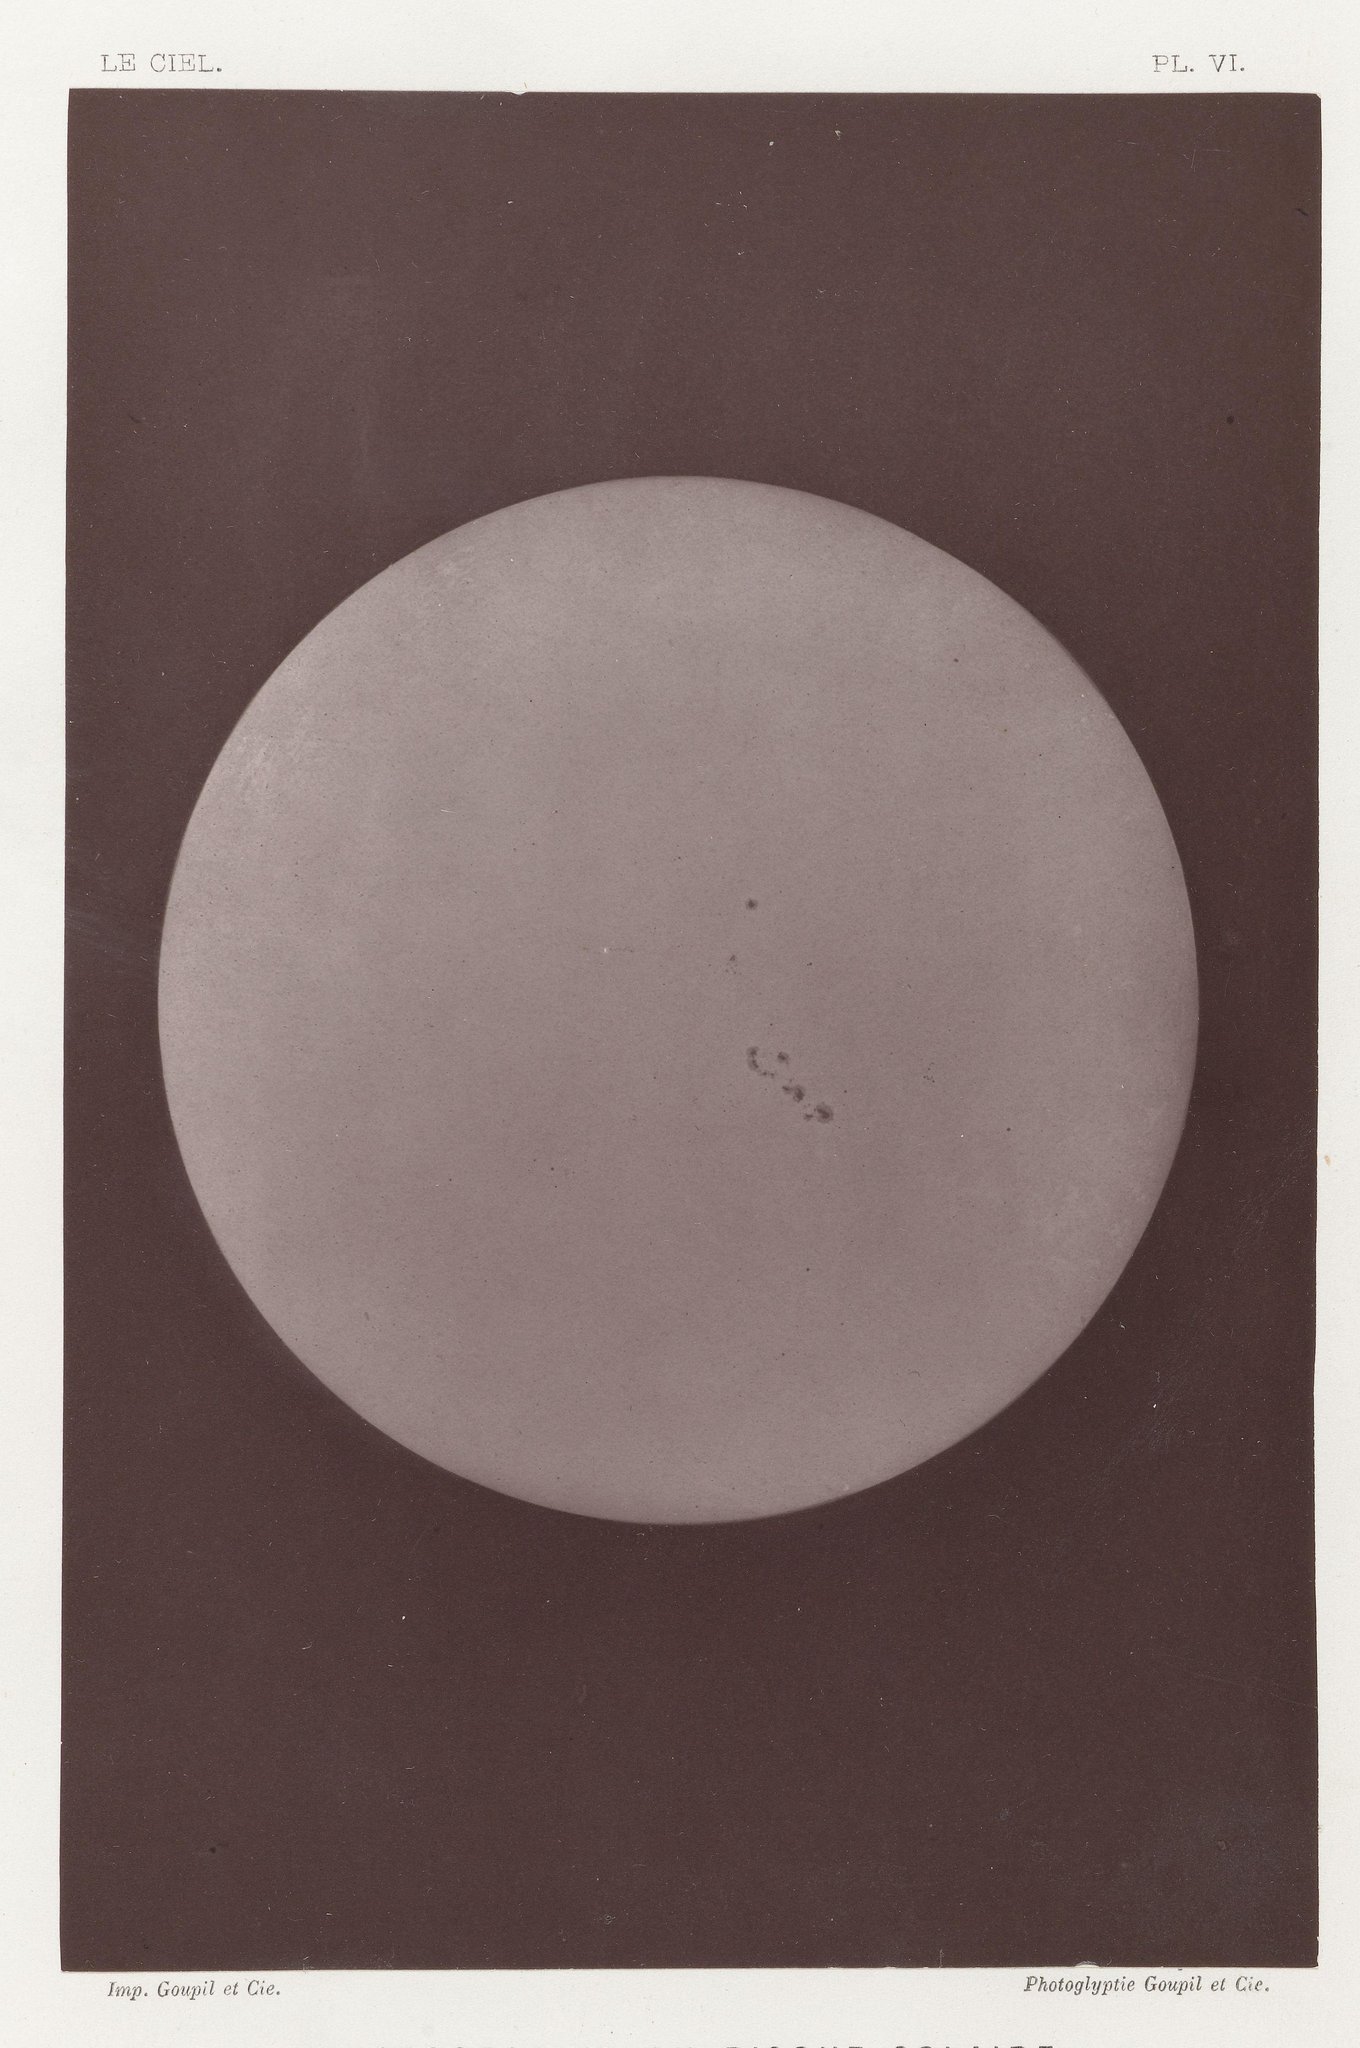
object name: page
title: Photographie du disque solaire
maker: pierre jules césar janssen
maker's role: astronoom, fotograaf, uitvinder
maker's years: 1824-1907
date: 1867-1877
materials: paper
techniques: woodburytype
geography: paris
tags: sun-spots, sun as celestial body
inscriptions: inscription: ‘Epreuve obtenue d'après (...) de 204 millimètres de diamètre.’